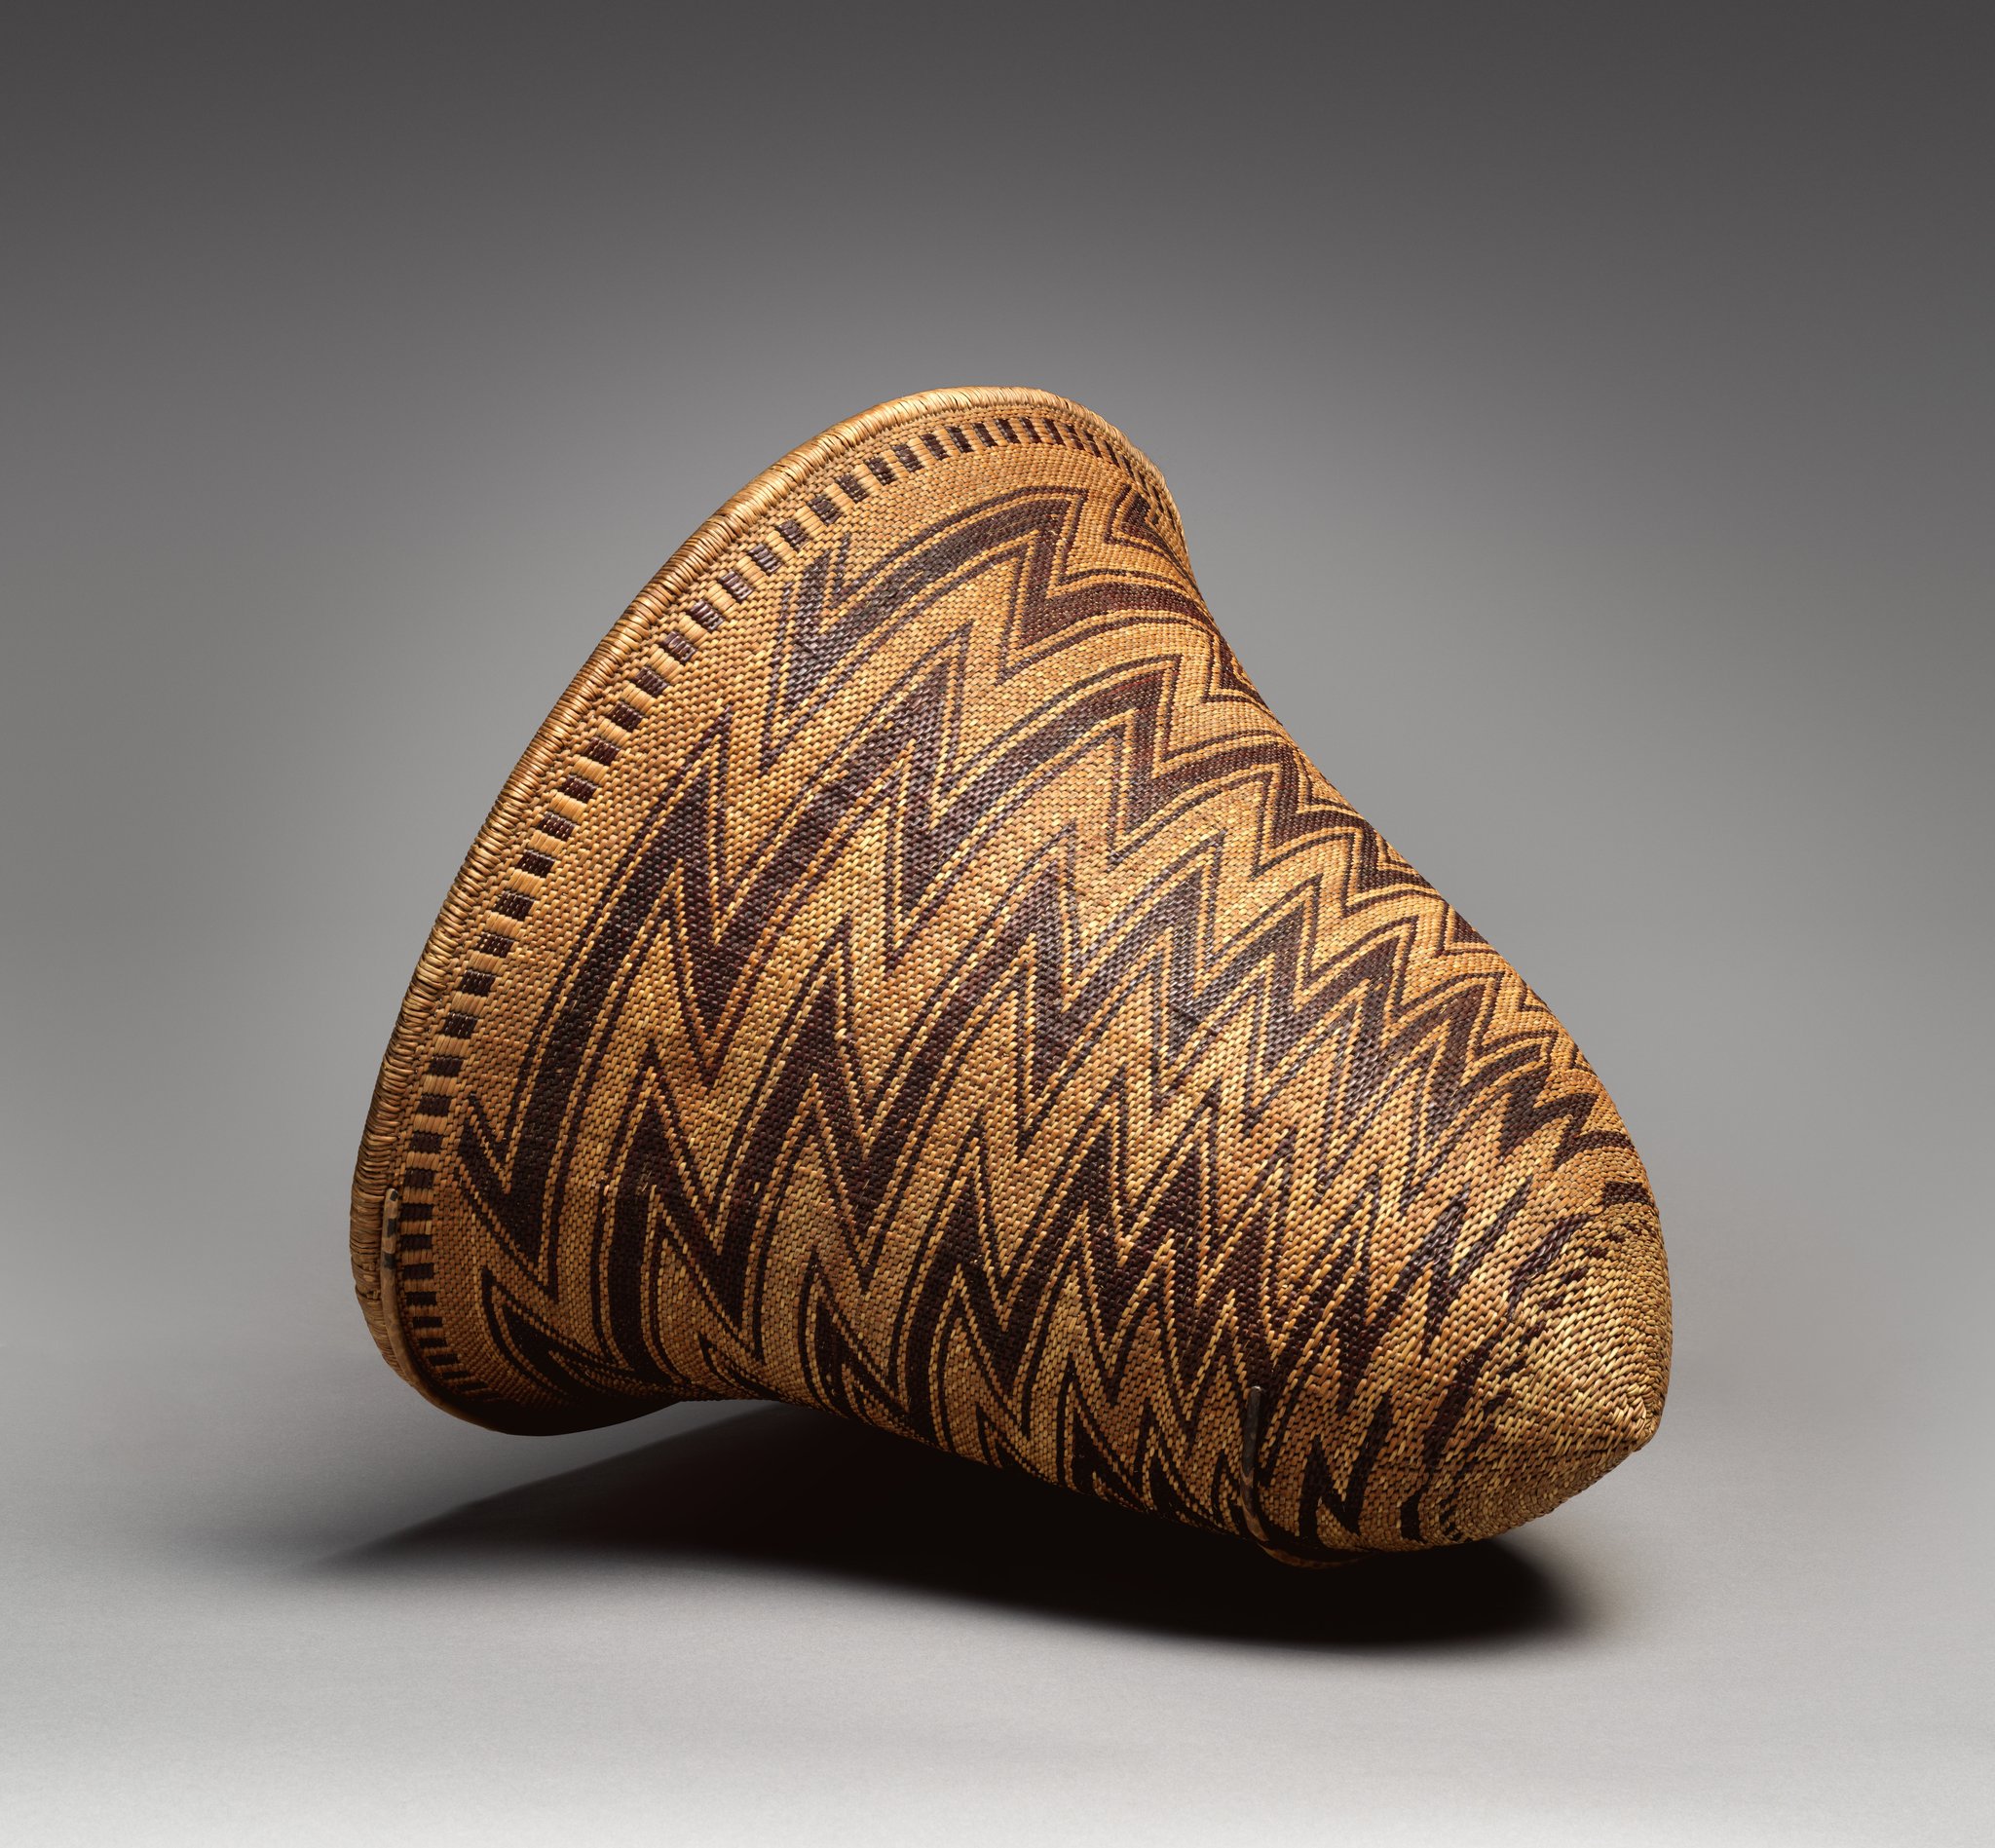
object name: carrying basket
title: Diagonally twined carrying basket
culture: pomo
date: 1900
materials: wood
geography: united states